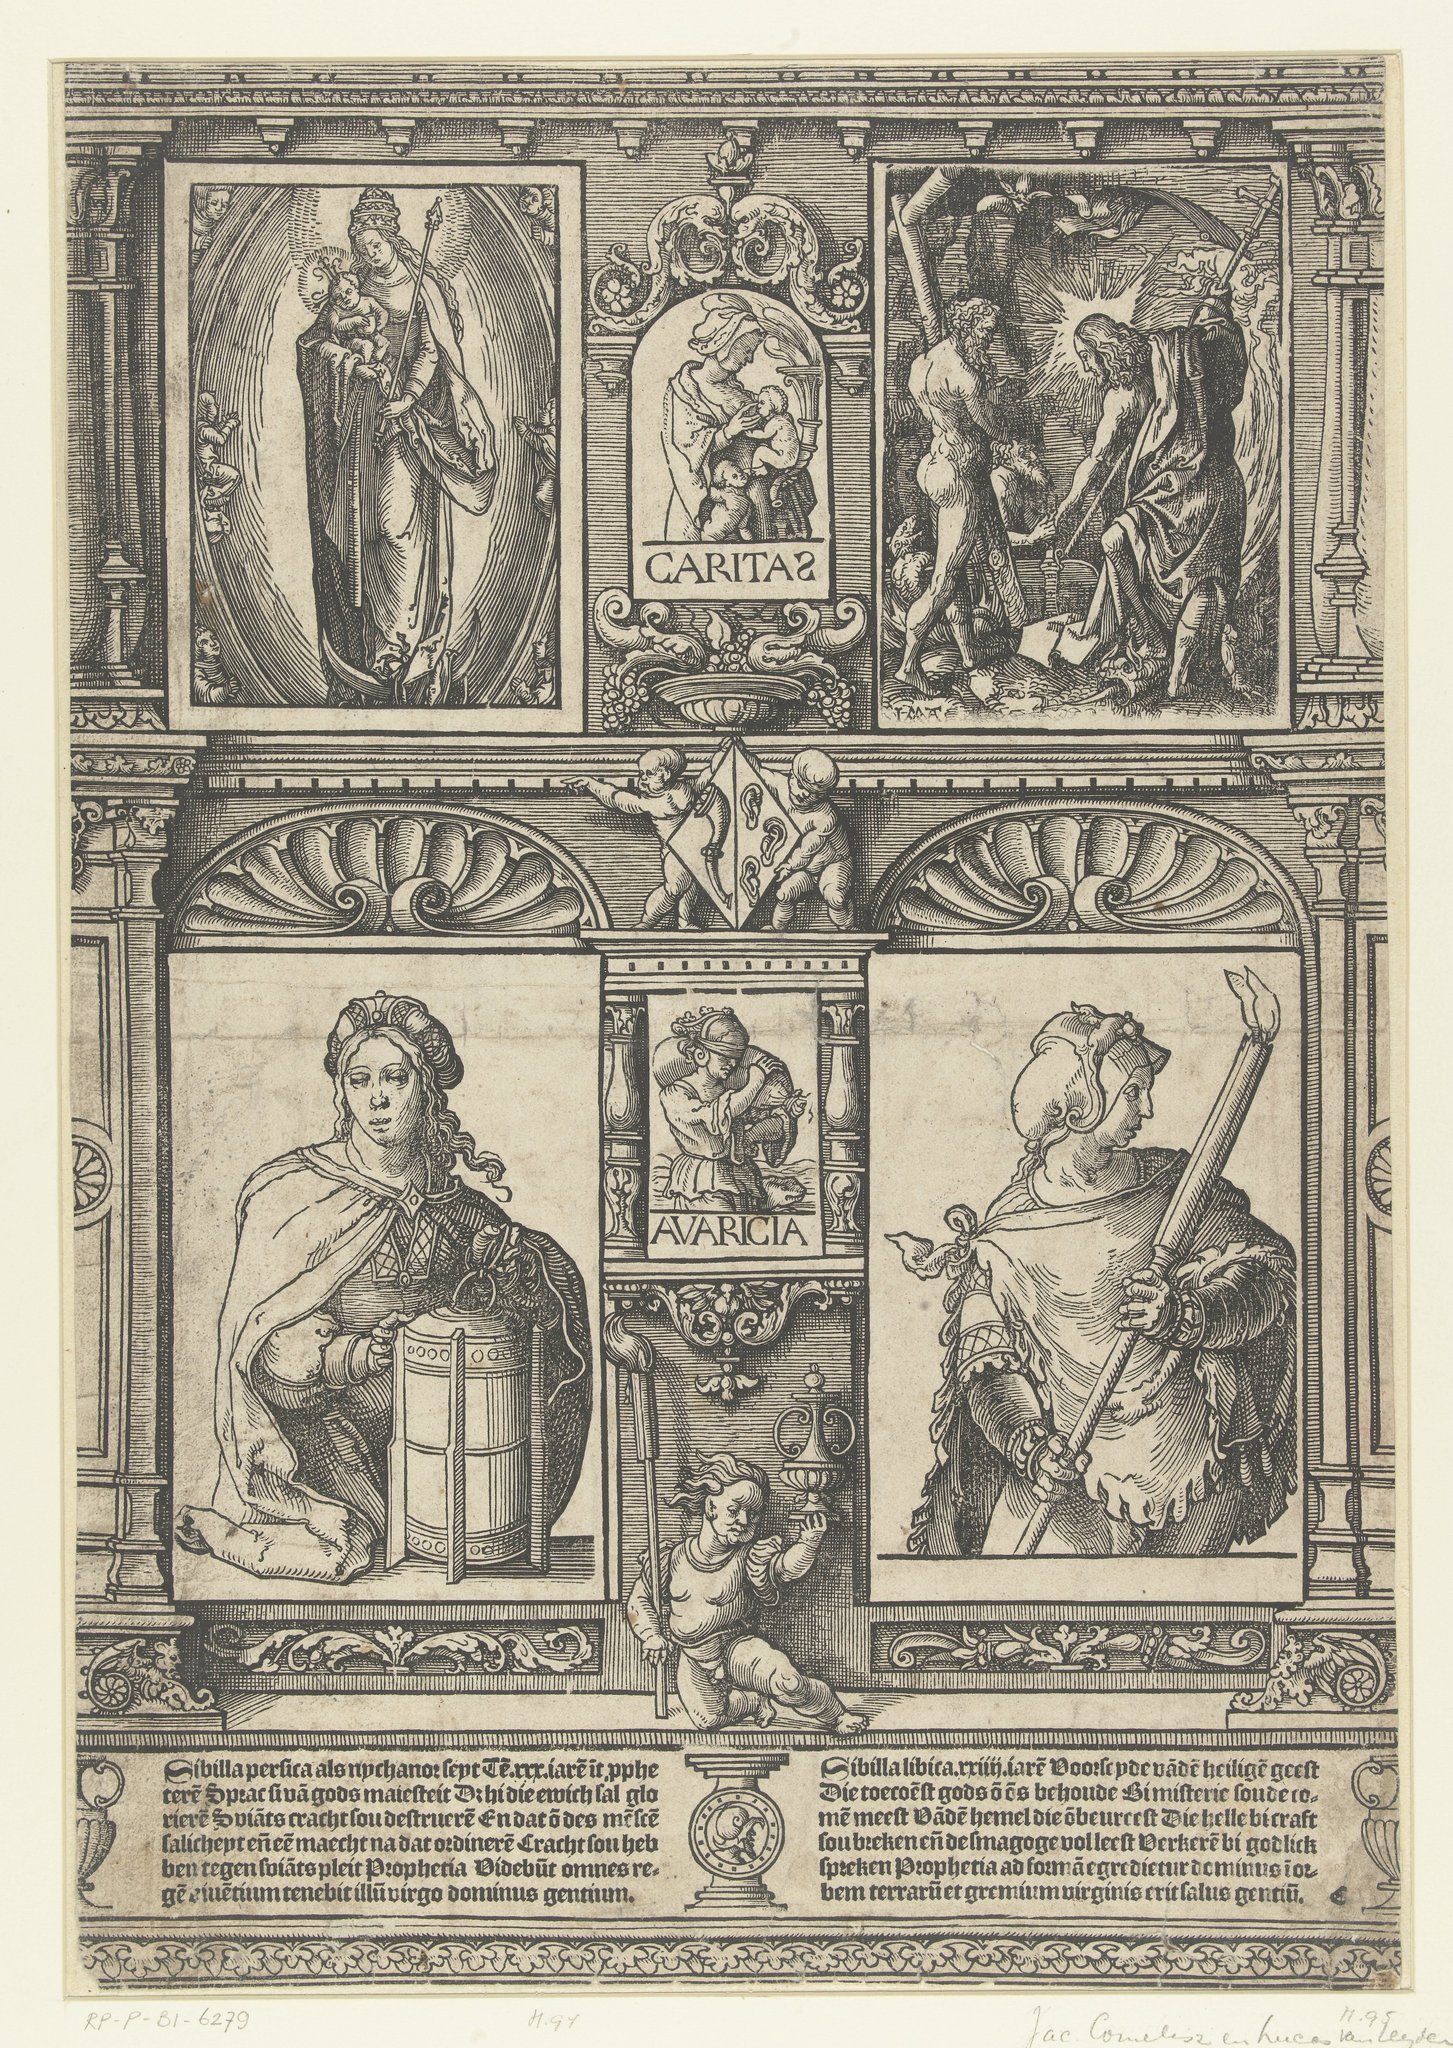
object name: print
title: Blad met twee Sibyllen en twee bijbelse scènes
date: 1520-1521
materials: paper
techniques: woodcut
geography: low countries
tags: charity, 'caritas'; 'carità' (ripa) ~ one of the three theological virtues, madonna on the crescent of the moon (sometimes called queen of heaven) (in mandorla), christ in the underworld, harrowing of hell, christ in limbo, 'descensus ad inferos', 'anastasis', covetousness; 'avaritia' (ripa) ~ personification of one of the seven deadly sins, sibyls (with name), persian sibyl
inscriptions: collector's mark: Lugt 2228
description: Uit serie van zeven bladen. Prent, gedrukt van meerdere blokken, vormt één geheel door ornamentele omlijsting. Linksboven Madonna op de maansikkel, rechtsboven Christus daalt af in de hel. Linksonder de Perzische sibylle met begeleidende tekst, rechtsonder de Libysche sibylle met begeleidende tekst. In omlijsting personificatie van de Liefdadigheid (Caritas) en de Hebzucht (Avaricia).